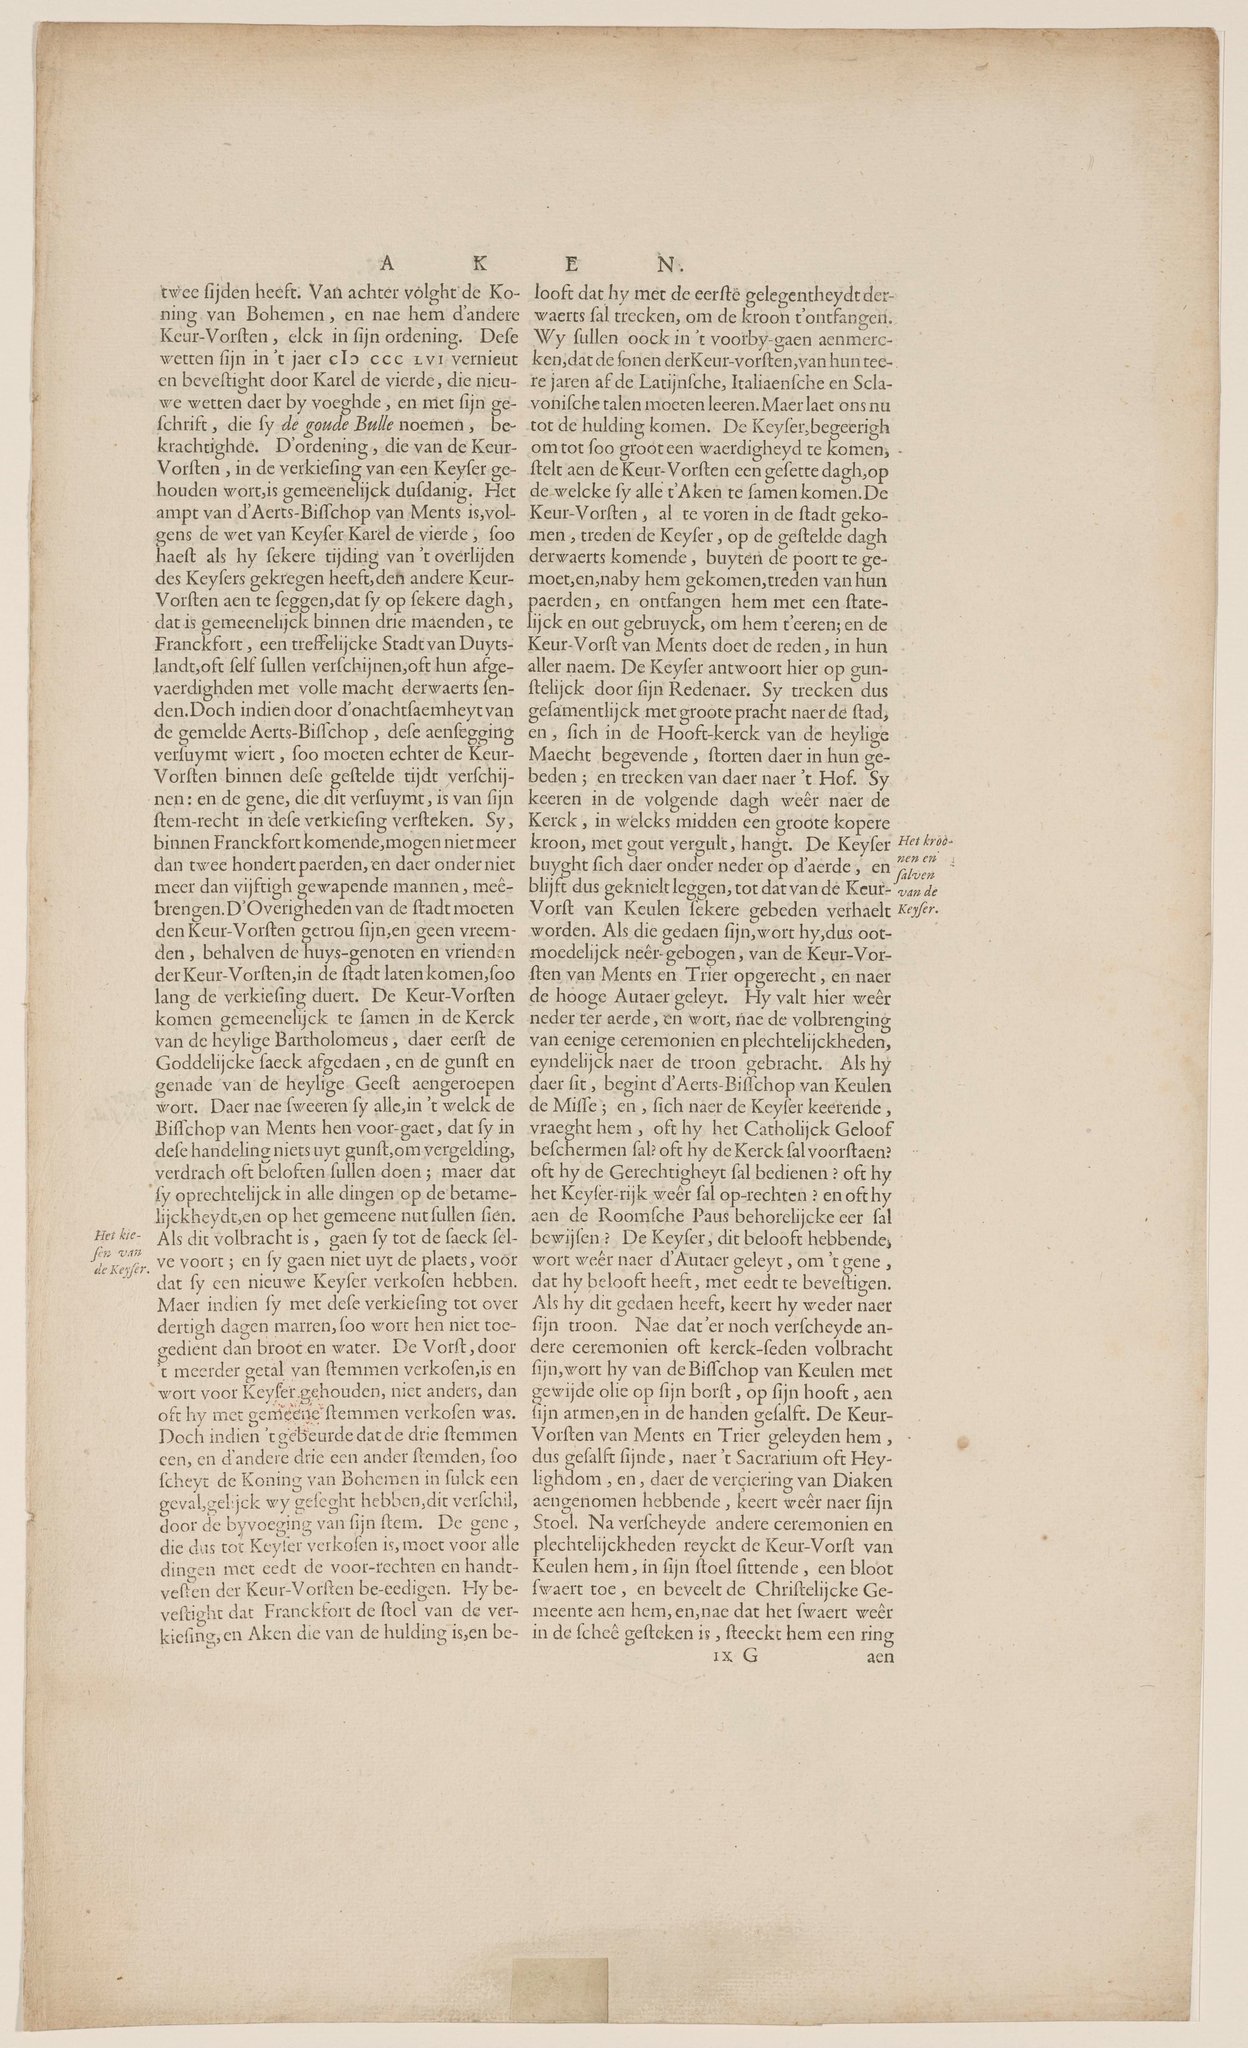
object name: text sheet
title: Aken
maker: johannes willemszoon blaeu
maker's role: printer, publisher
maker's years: 1596-1673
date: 1652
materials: paper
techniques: letterpress printing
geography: amsterdam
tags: aken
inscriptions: collector's mark: Lugt 2228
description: Tekst gebruikt in: Blaeu, Johannes Willemszoon. Toonneel der steden van de Vereenighde Nederlanden. 2 delen. Amsterdam: Johannes Willemszoon Blaeu, 1652, dl. 2. Zie ook: RP-P-AO-19-79-1.